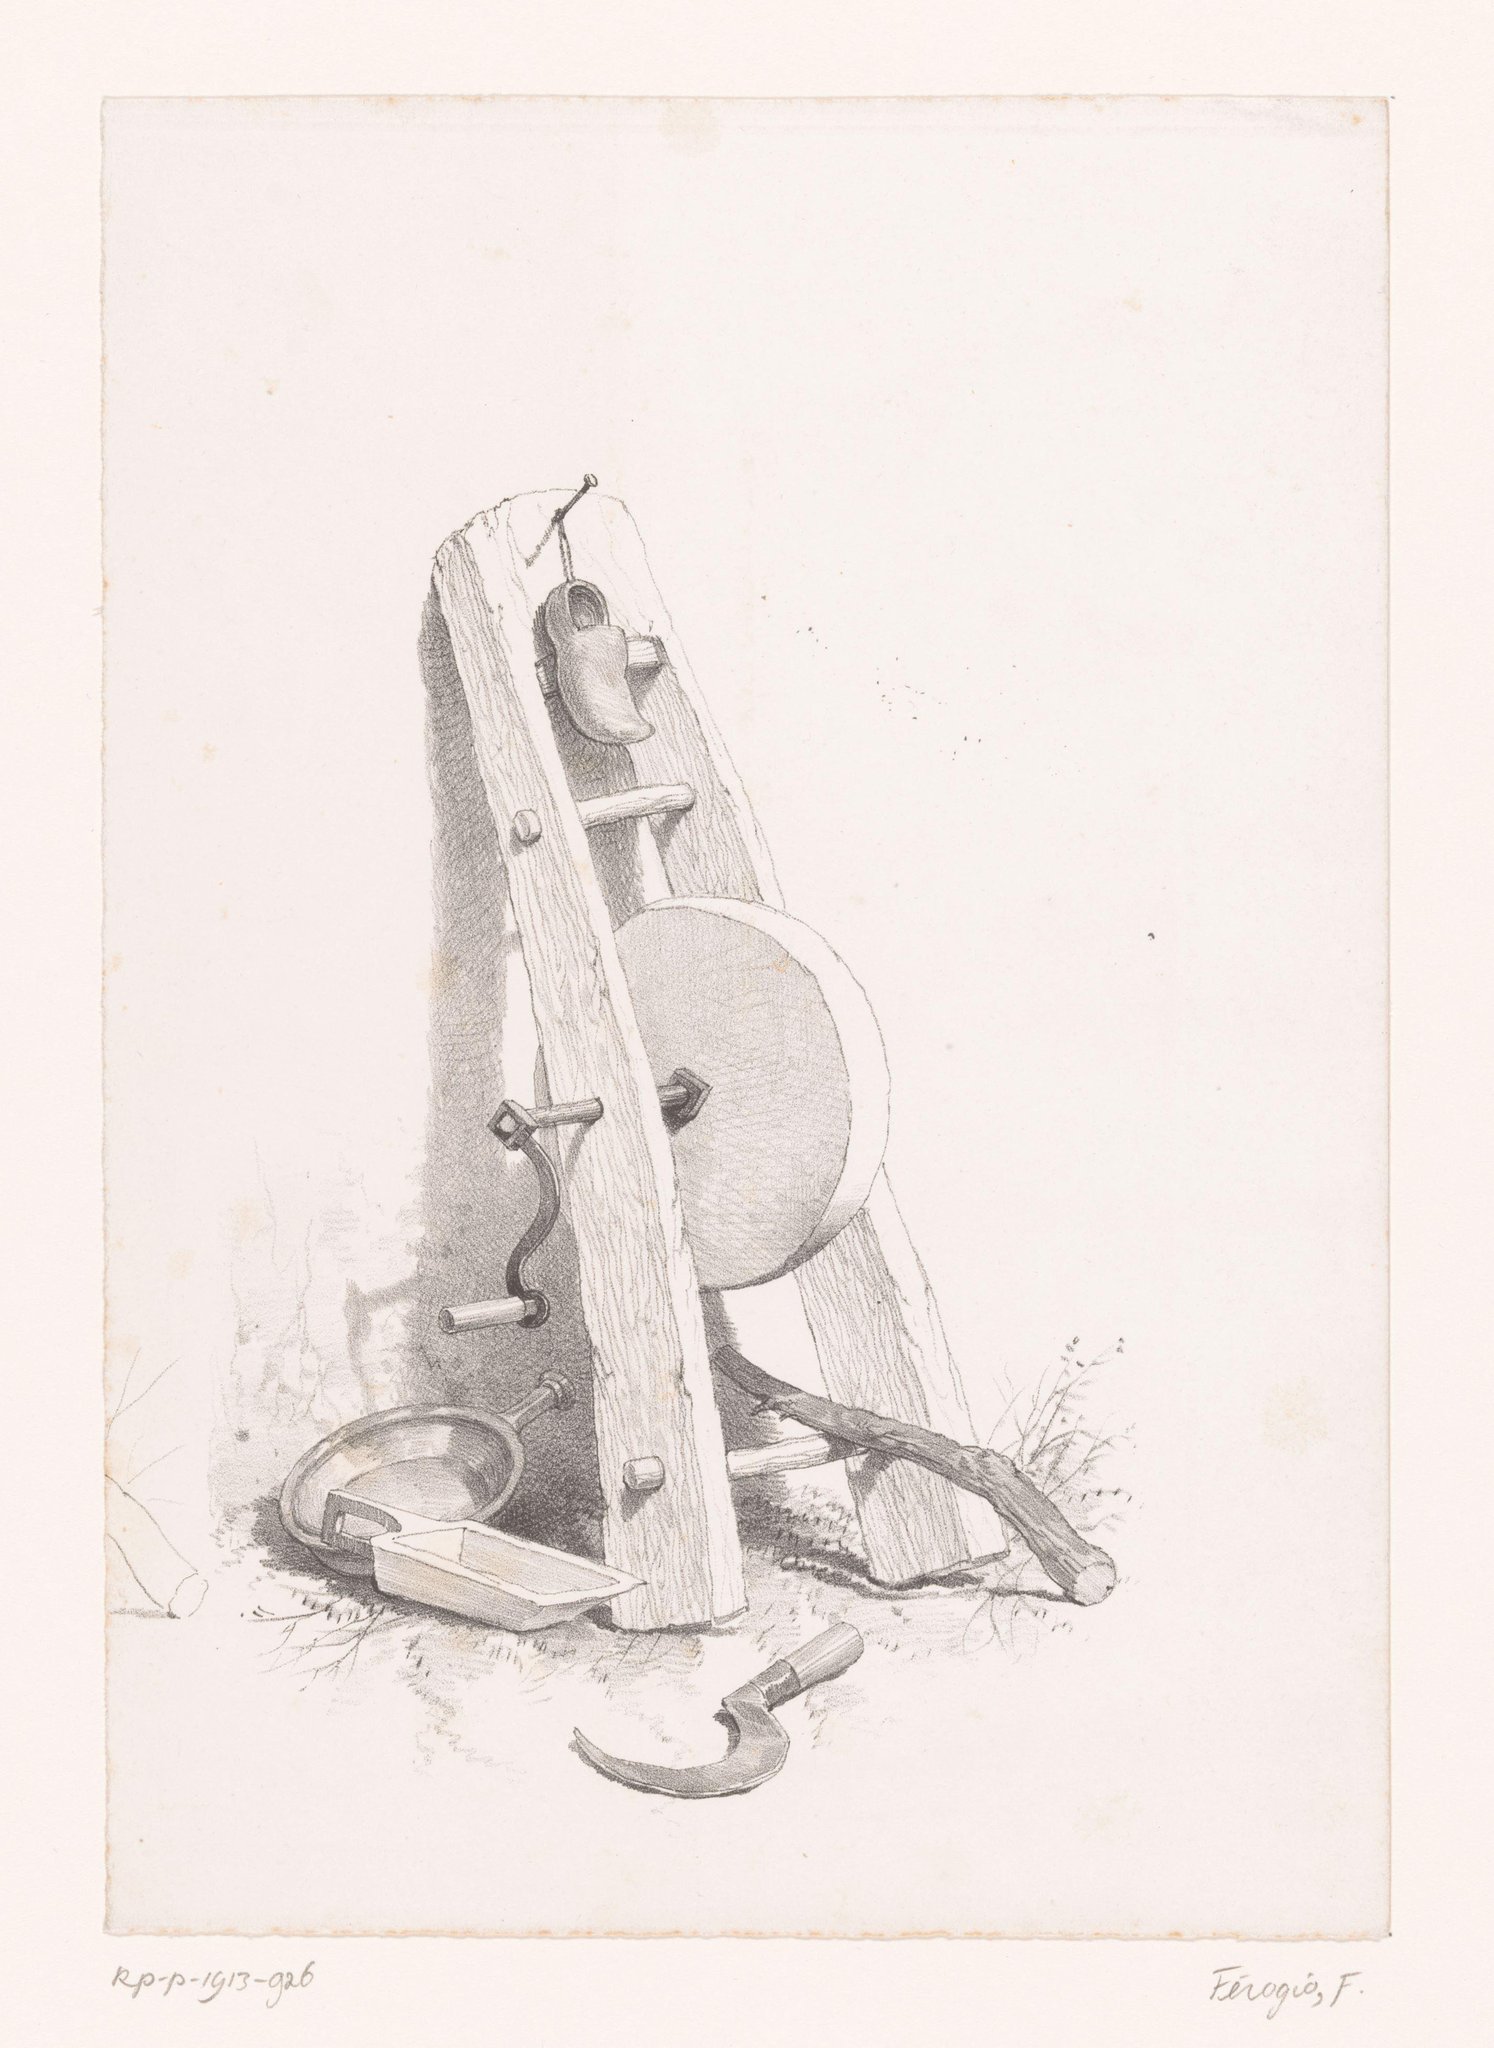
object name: print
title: Molensteen met voorwerpen van een boer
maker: fortuné férogio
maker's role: print maker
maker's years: 1805-1888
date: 1829-1875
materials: paper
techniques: lithograph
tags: wooden shoes, clogs, parts of machines: mill-stone, agricultural implements: sickle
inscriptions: collector's mark: Lugt 2228a